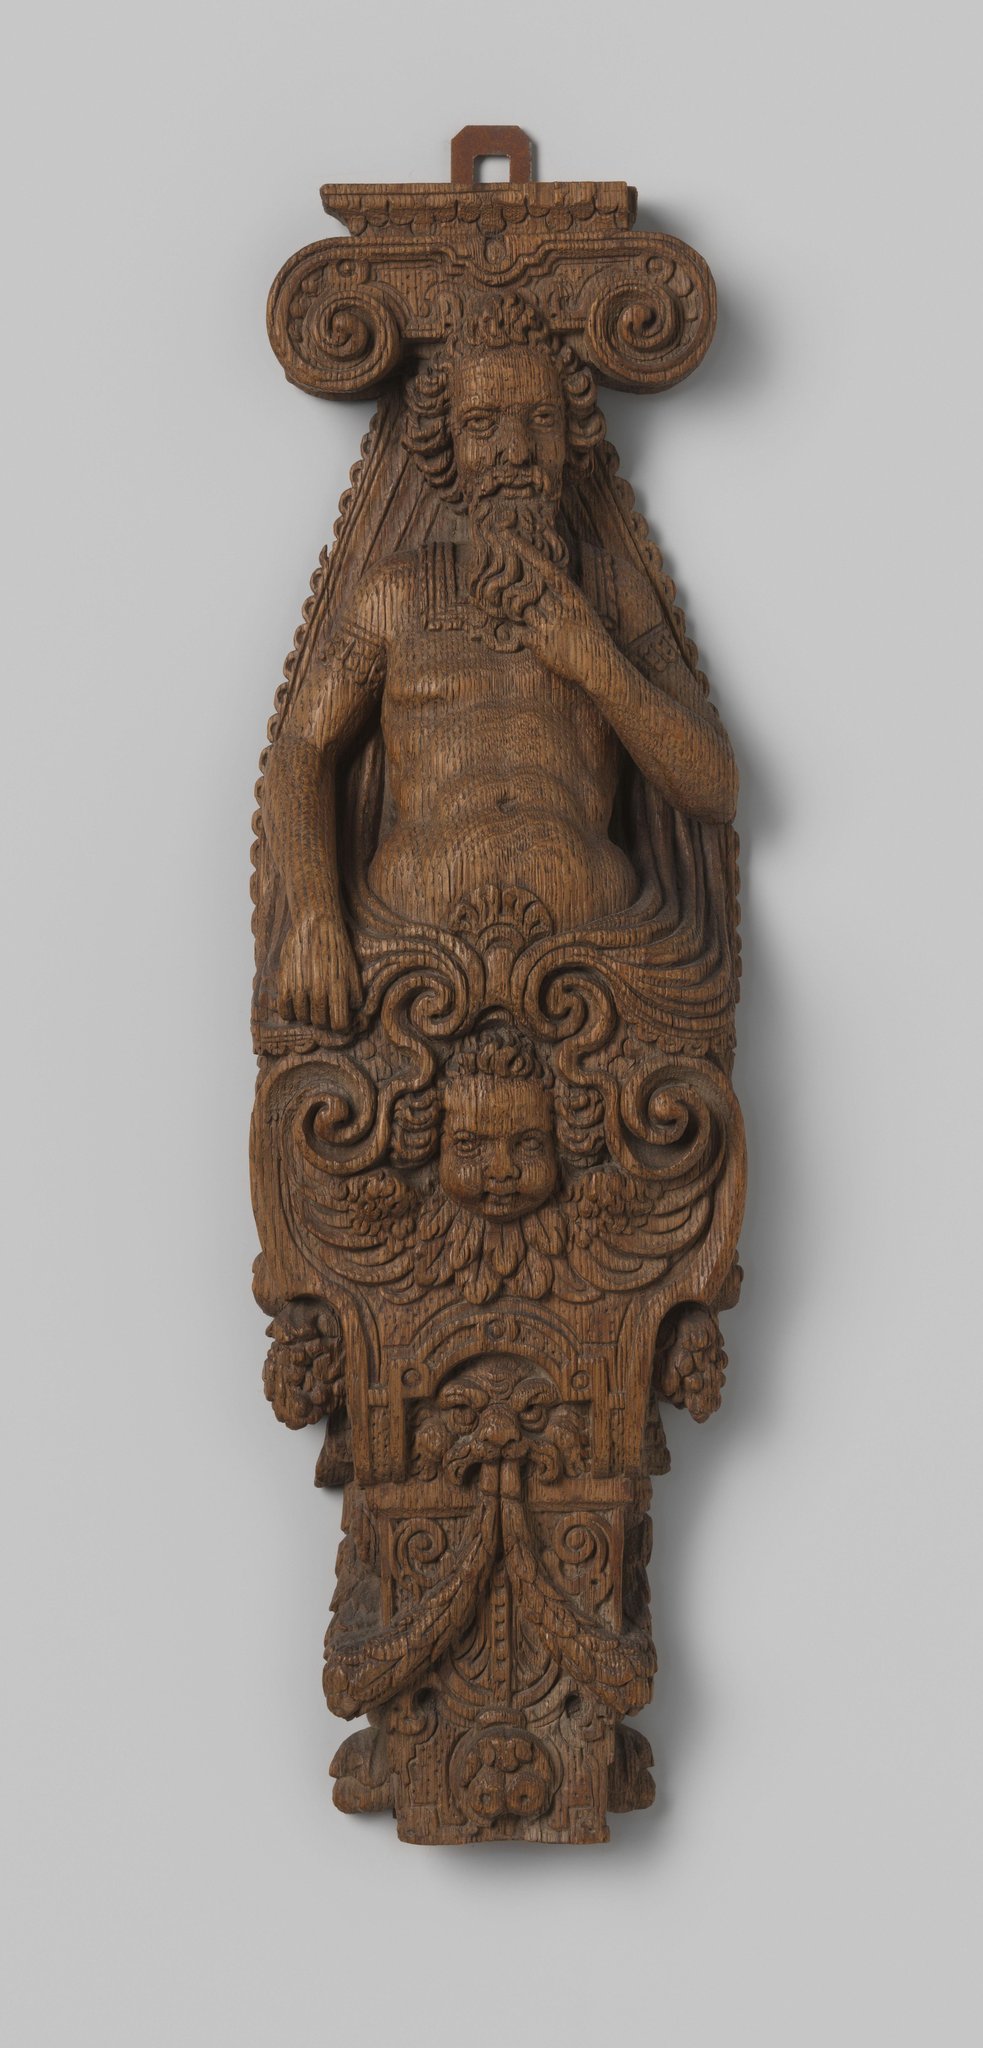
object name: furniture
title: Gebeeldhouwde hermatlant en hermkariatide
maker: Anonymous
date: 1600-1649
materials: wood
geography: northern netherlands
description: Een gebeeldhouwde hermatlant en hermcaryatide van eikenhout . Waarschijnlijk fragmenten van een beeldenkast. Zie: BK-16714-a/c.